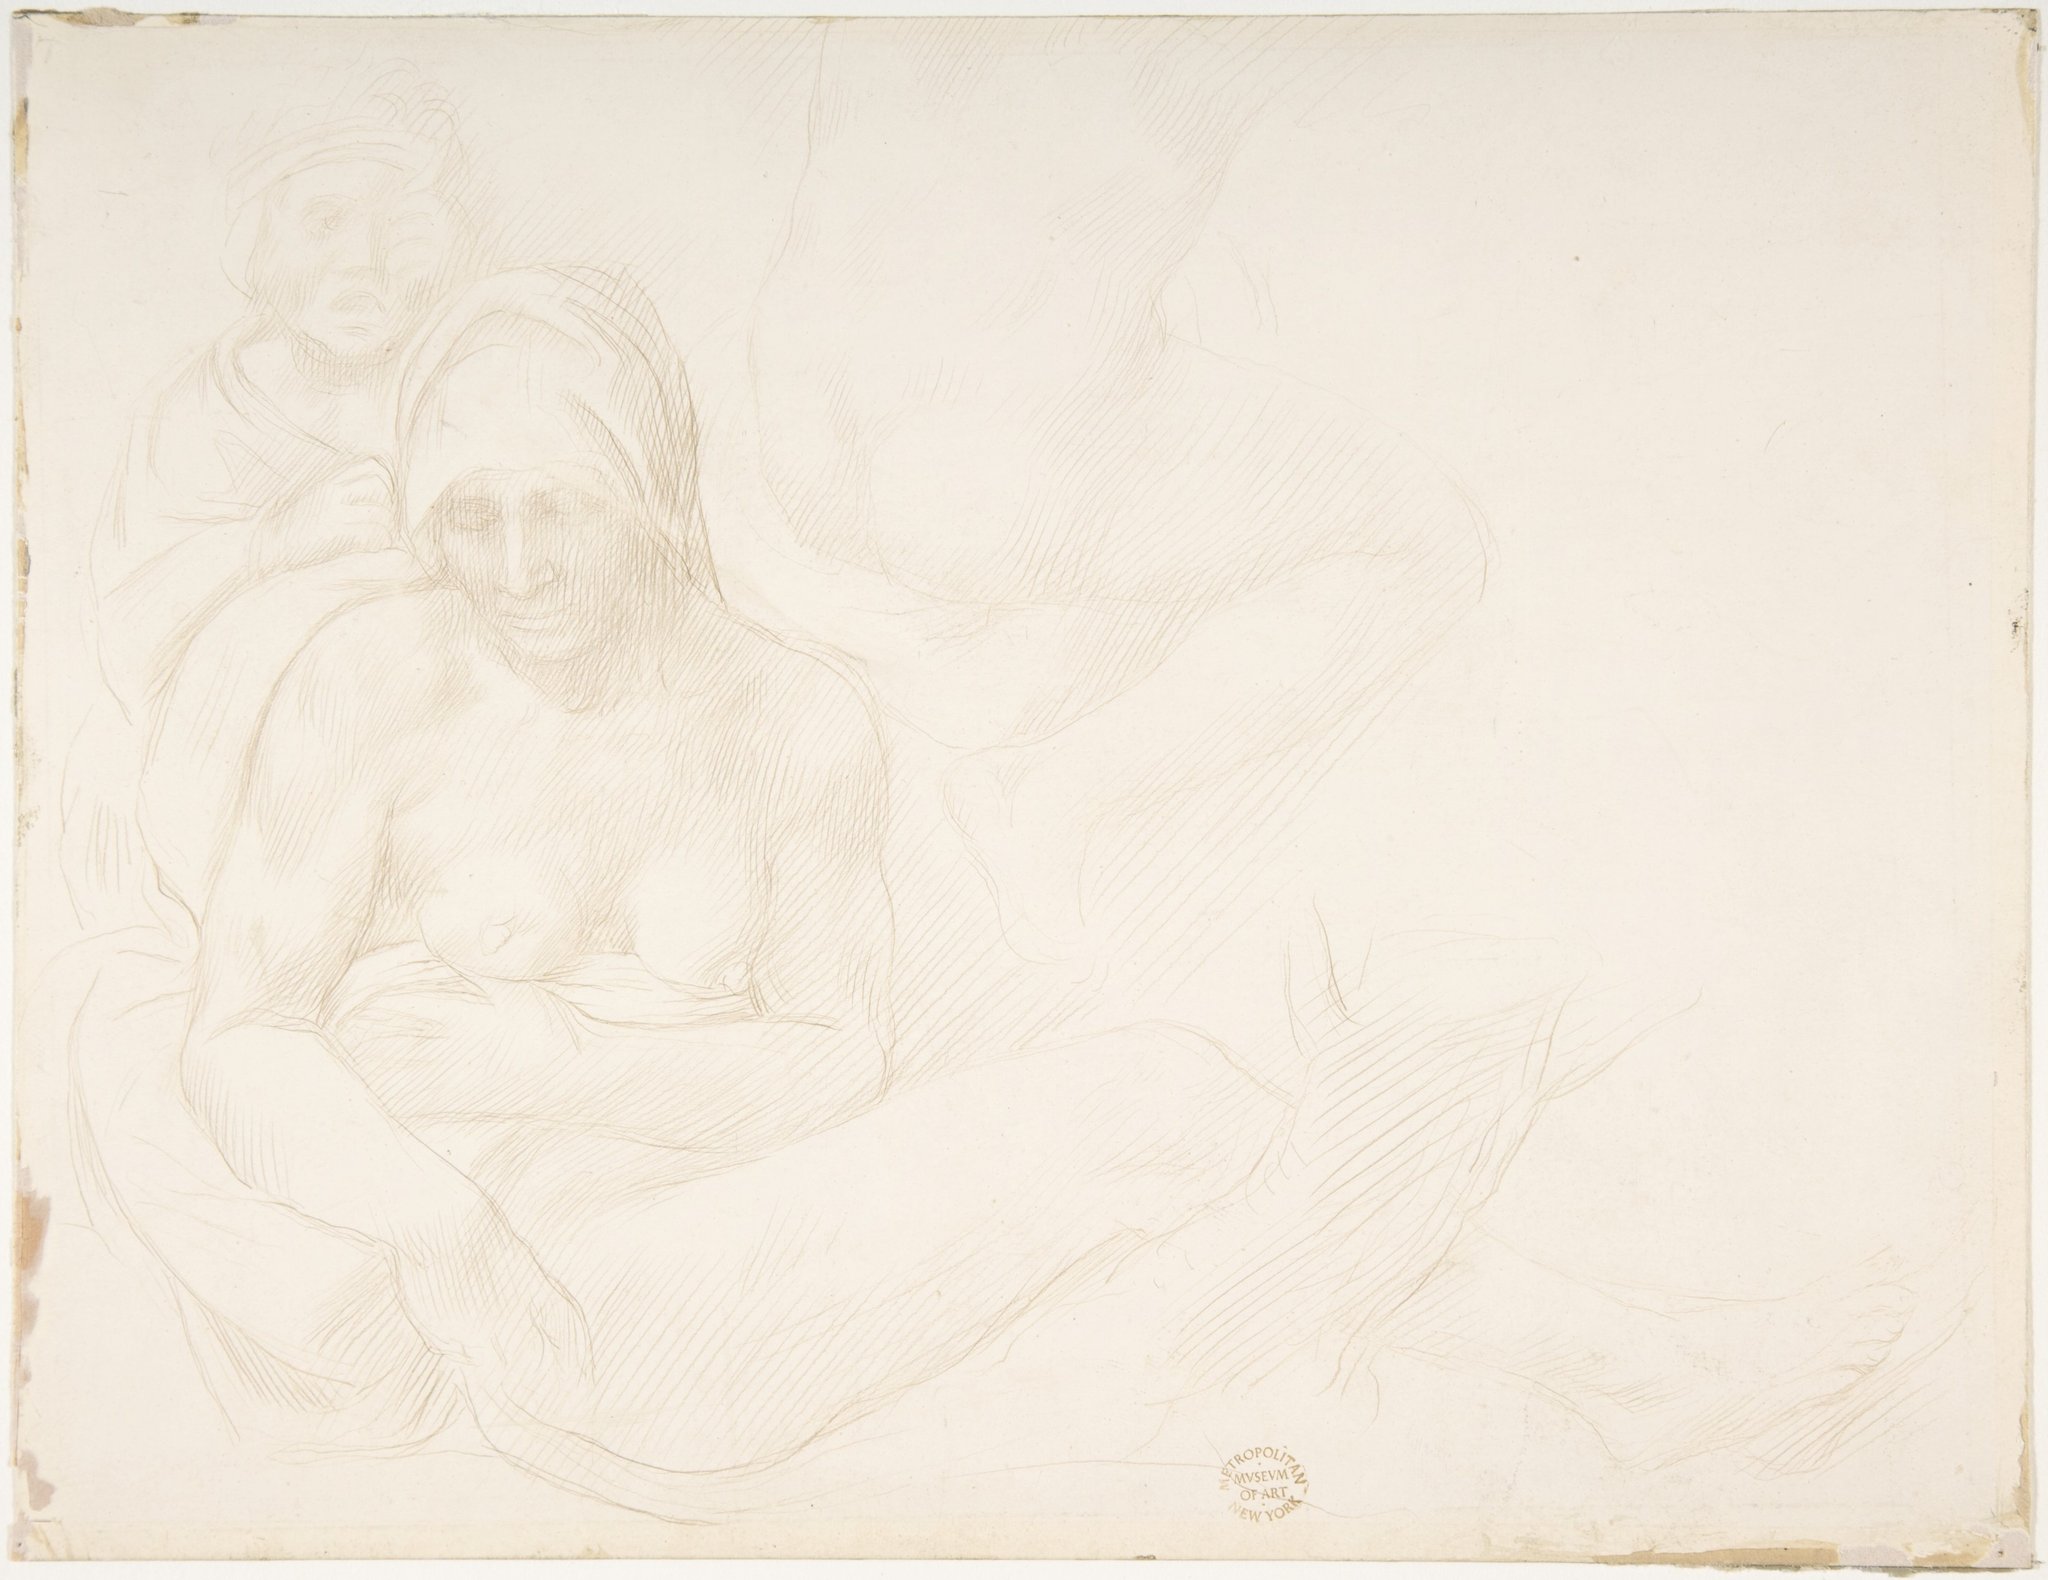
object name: drawing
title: Figures from "The Deluge" of Michelangelo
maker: alphonse legros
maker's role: artist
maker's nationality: french and british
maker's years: 1837-1911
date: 1837-1911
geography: france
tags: female nudes